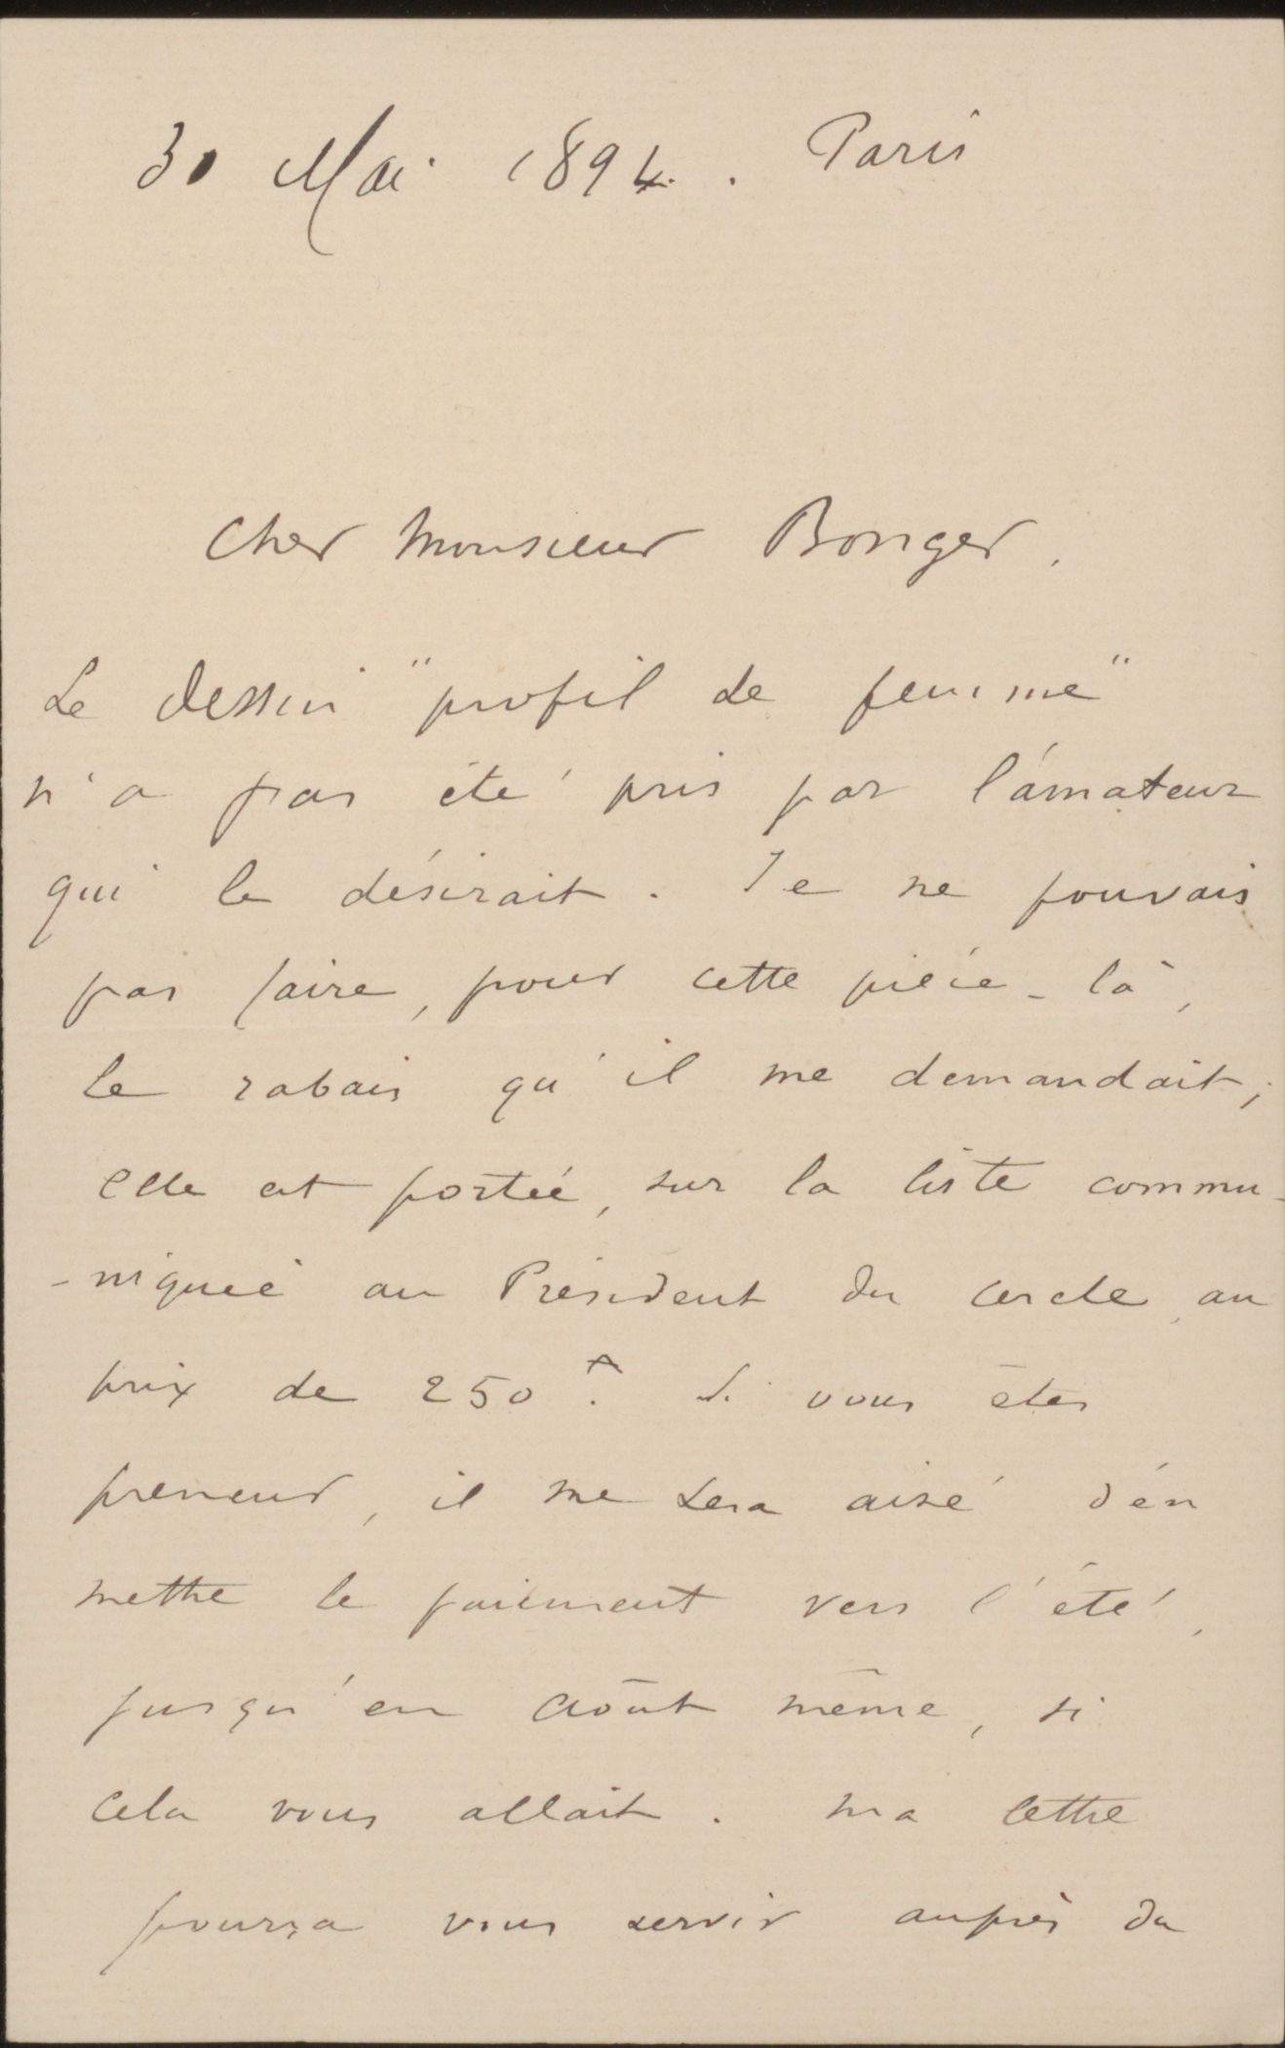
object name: letter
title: Brief aan Andries Bonger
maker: odilon redon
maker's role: draughtsman, painter, print maker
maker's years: 1840-1916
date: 1894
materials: ink, paper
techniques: pen, writing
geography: paris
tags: amsterdam, andries bonger, drawing, exhibition ~ art, historical persons (portraits and scenes from the life), money, the hague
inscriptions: watermark